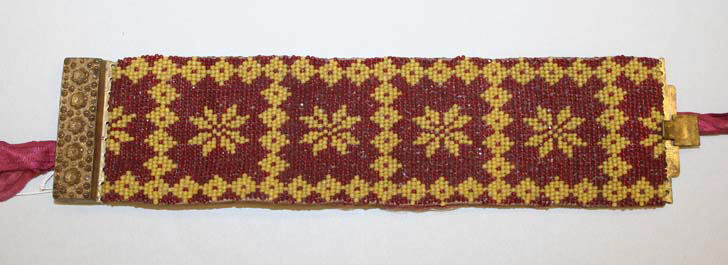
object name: bracelet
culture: american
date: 1834-1866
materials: metal